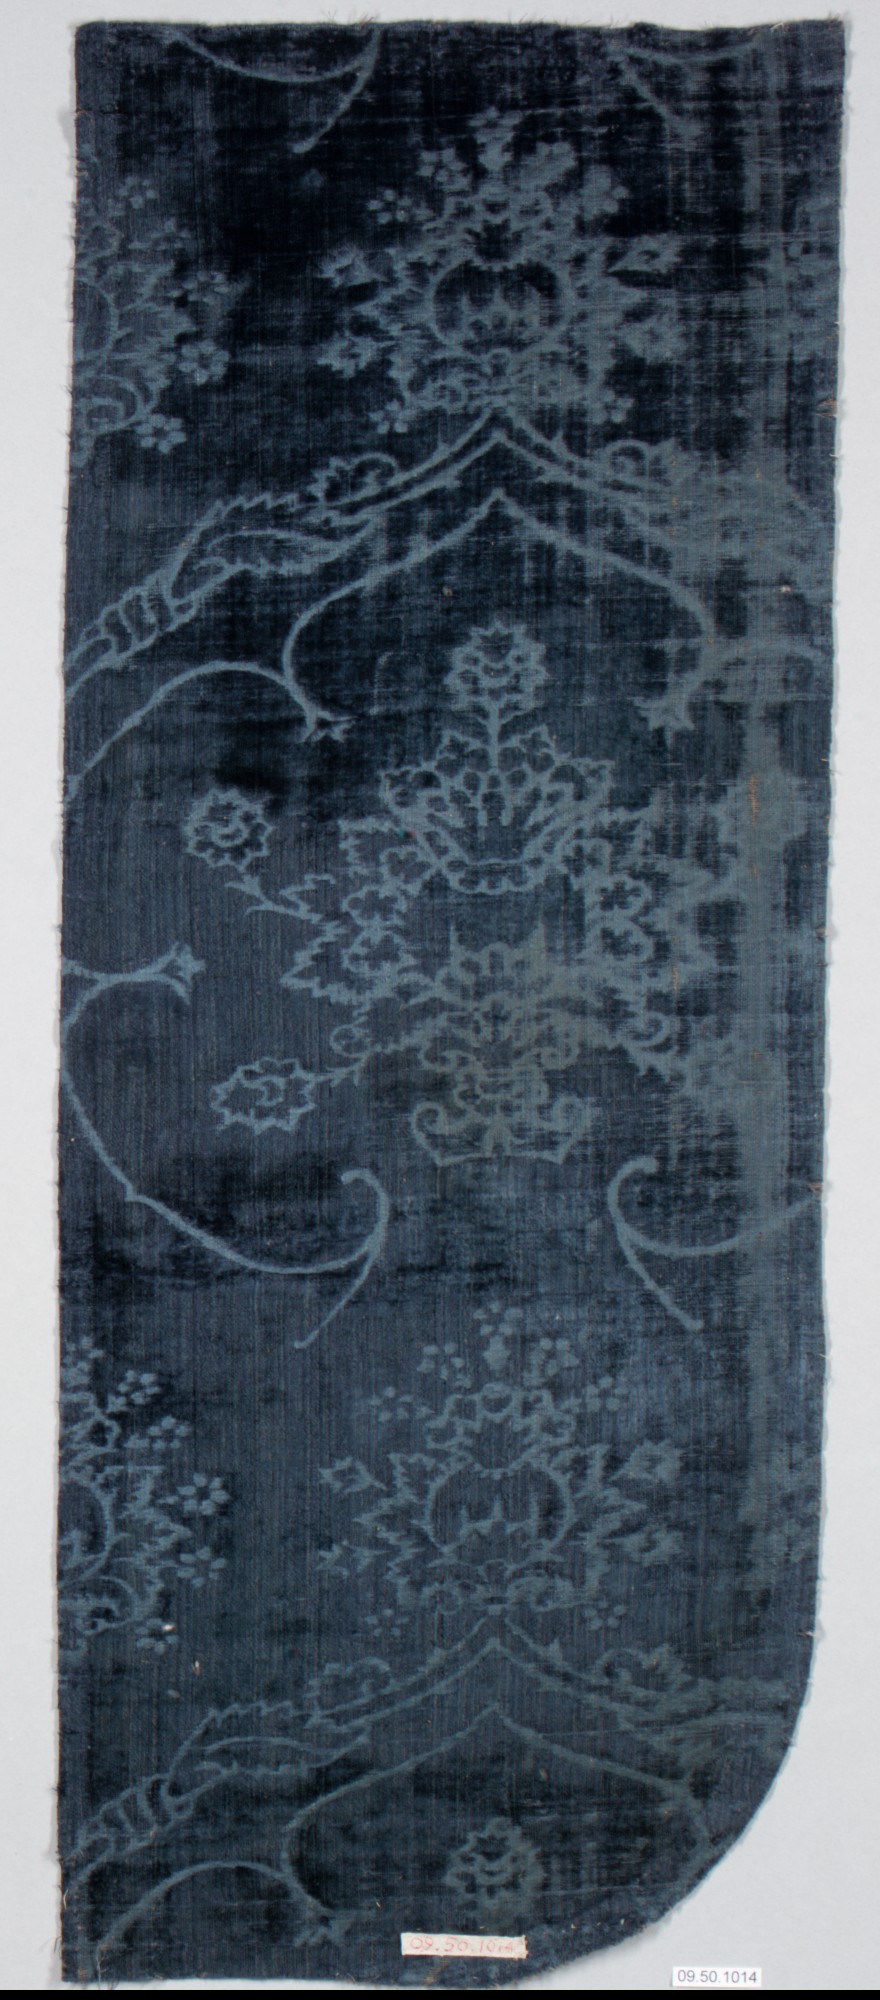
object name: piece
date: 1401-1500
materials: silk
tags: flowers,leaves